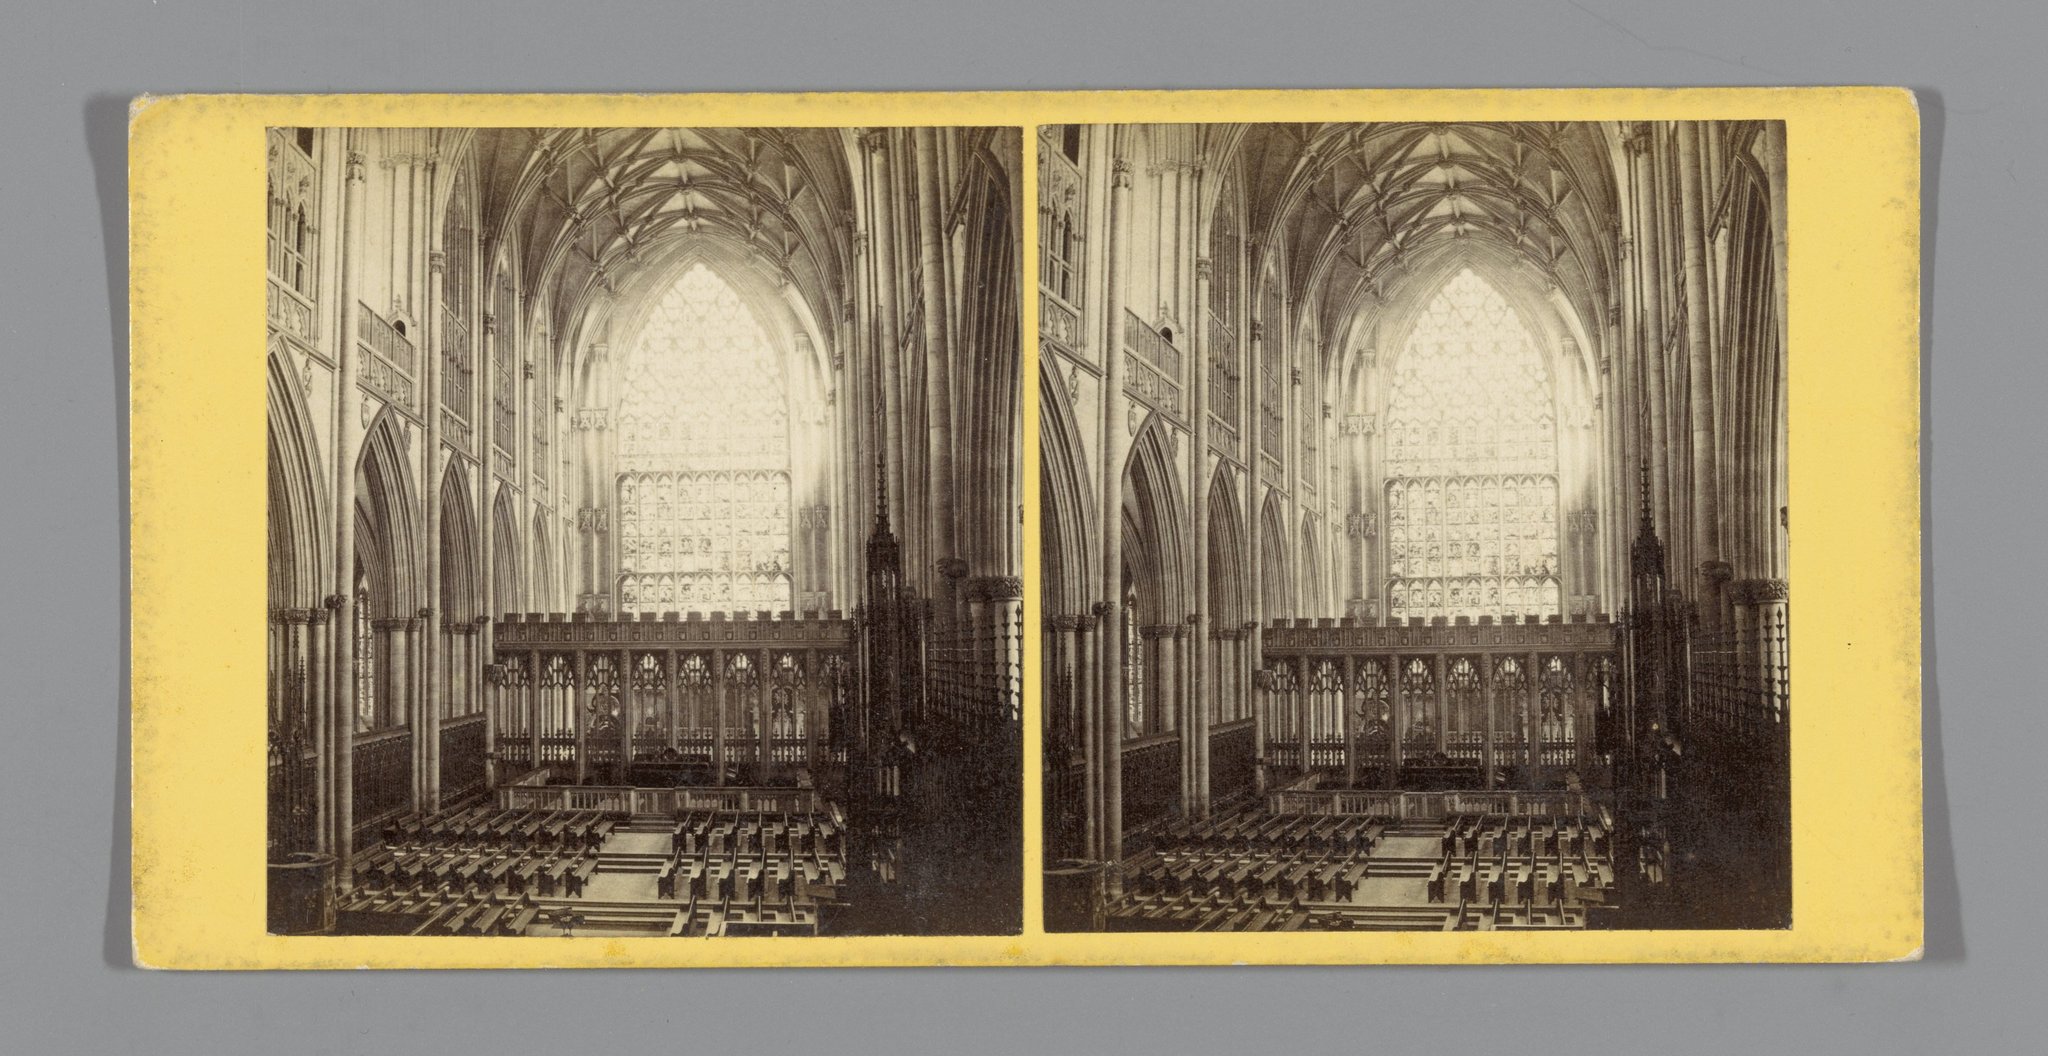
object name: stereograph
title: York Minster-The Choir, looking East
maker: george washington wilson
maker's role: publisher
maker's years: 1823-1893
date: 1850-1880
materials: cardboard, photographic support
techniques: albumen print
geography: york cathedral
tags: parts of church interior: choir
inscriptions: name: ‘G. W. Wilson, Photographer, Aberdeen.’, number: ‘No. 372.’